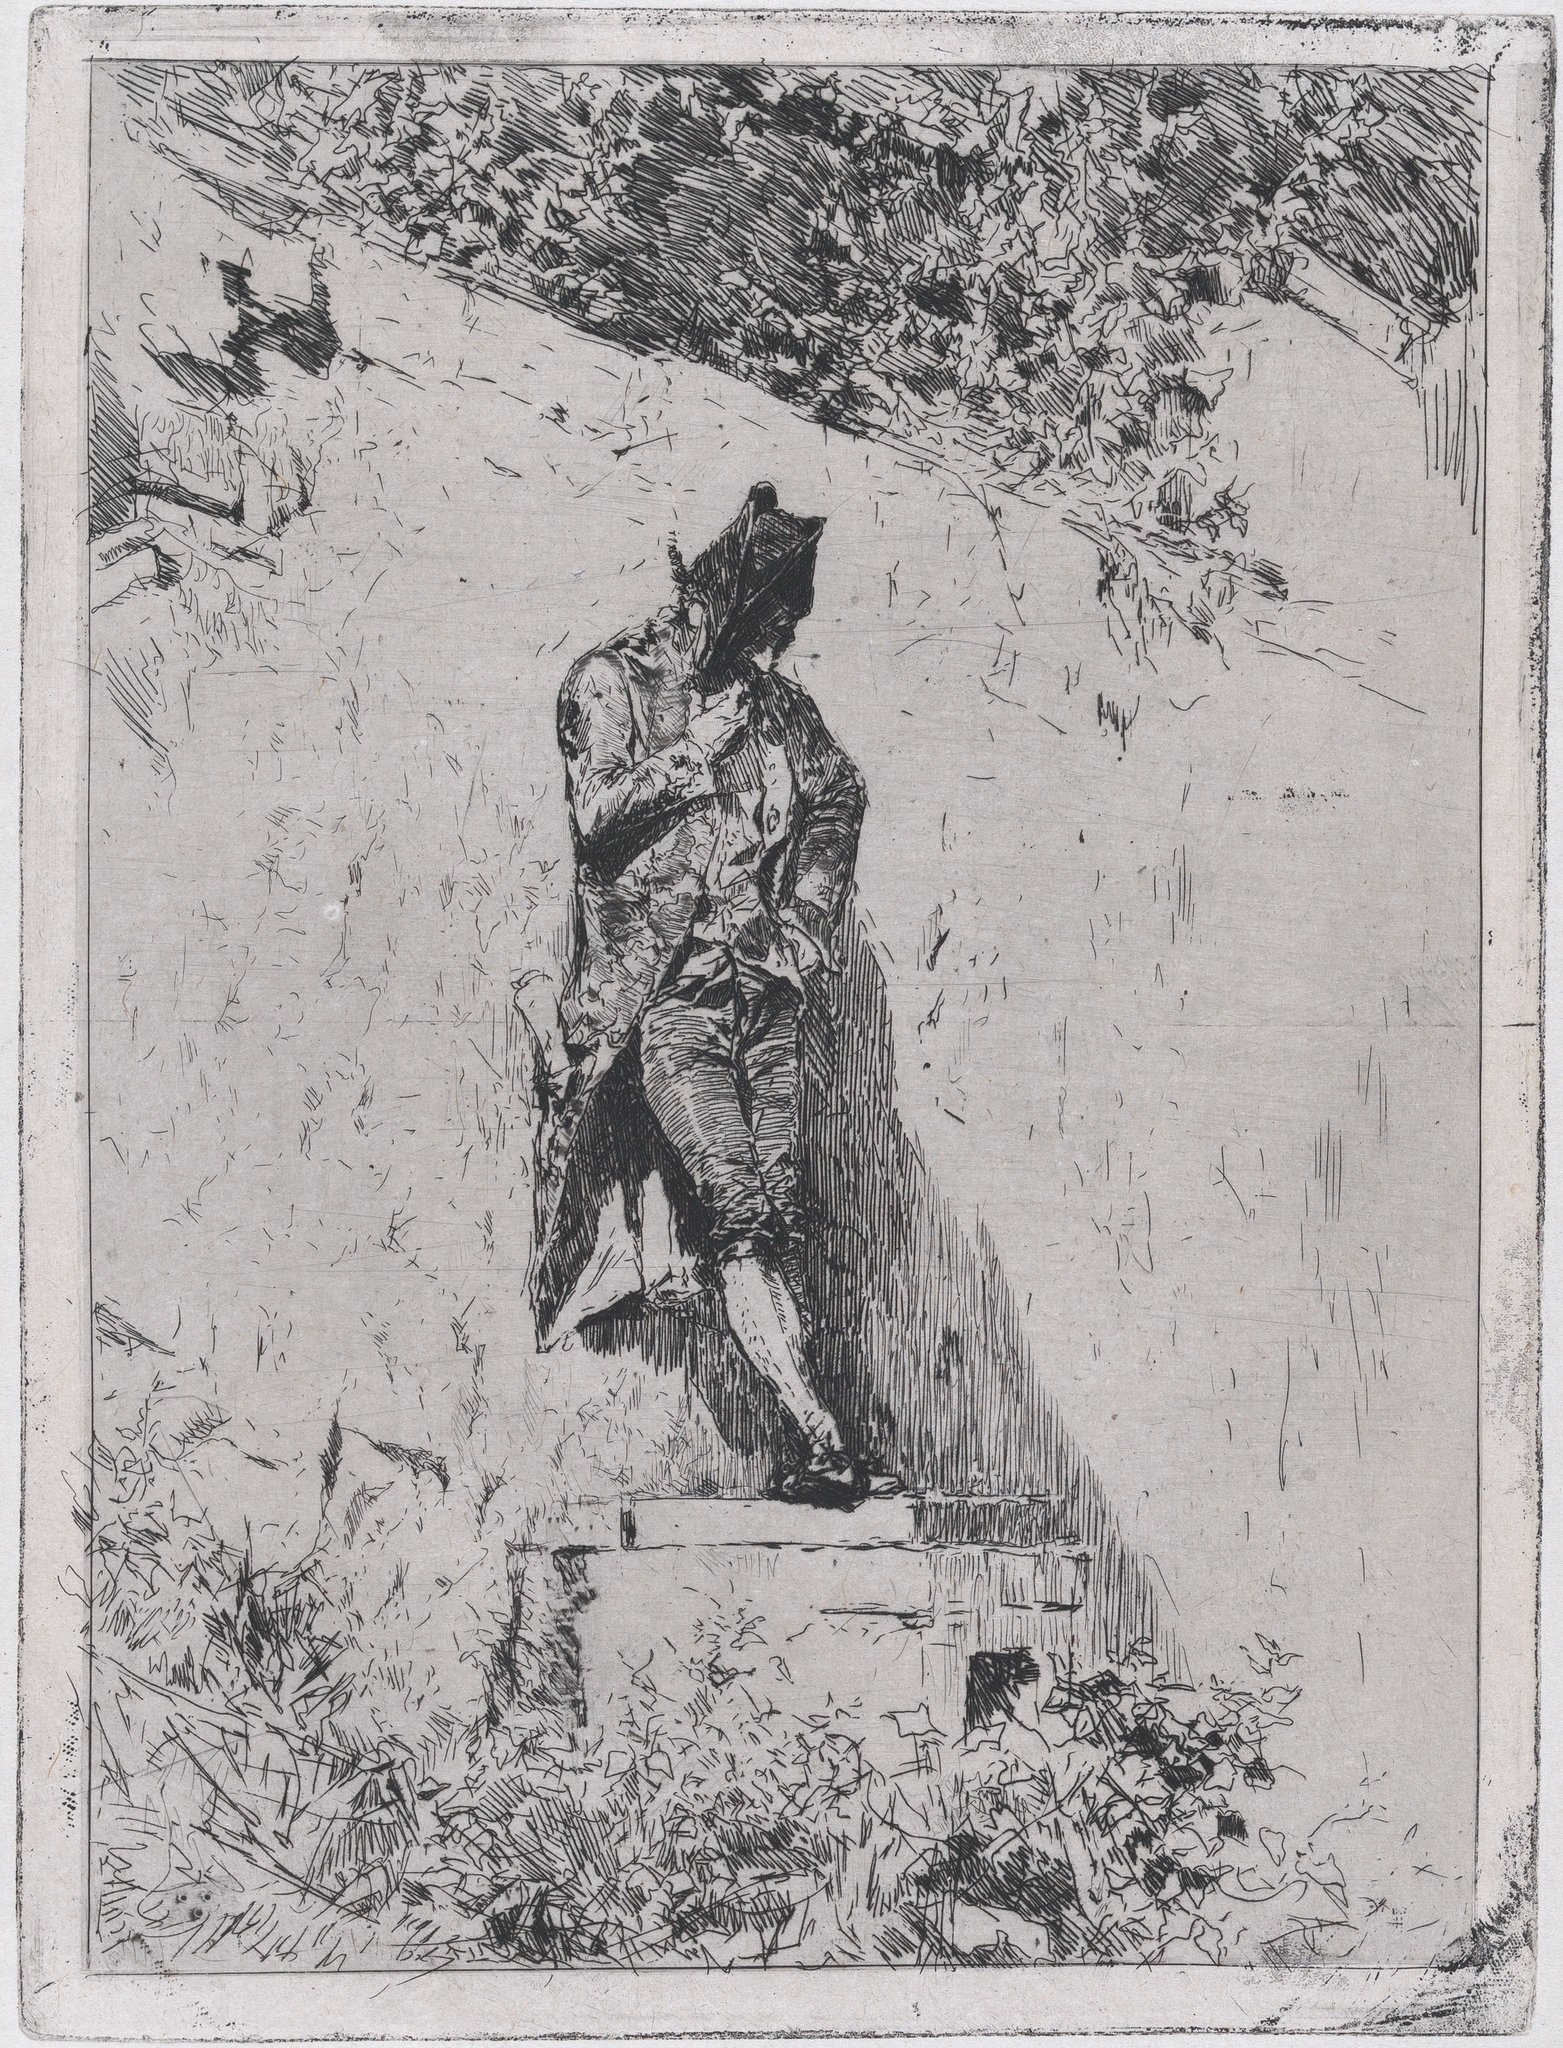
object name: print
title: Meditation: a man standing on a step by a wall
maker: mariano fortuny, 1838–1874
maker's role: artist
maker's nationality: spanish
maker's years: 1838-1874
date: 1865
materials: paper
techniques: etching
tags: men